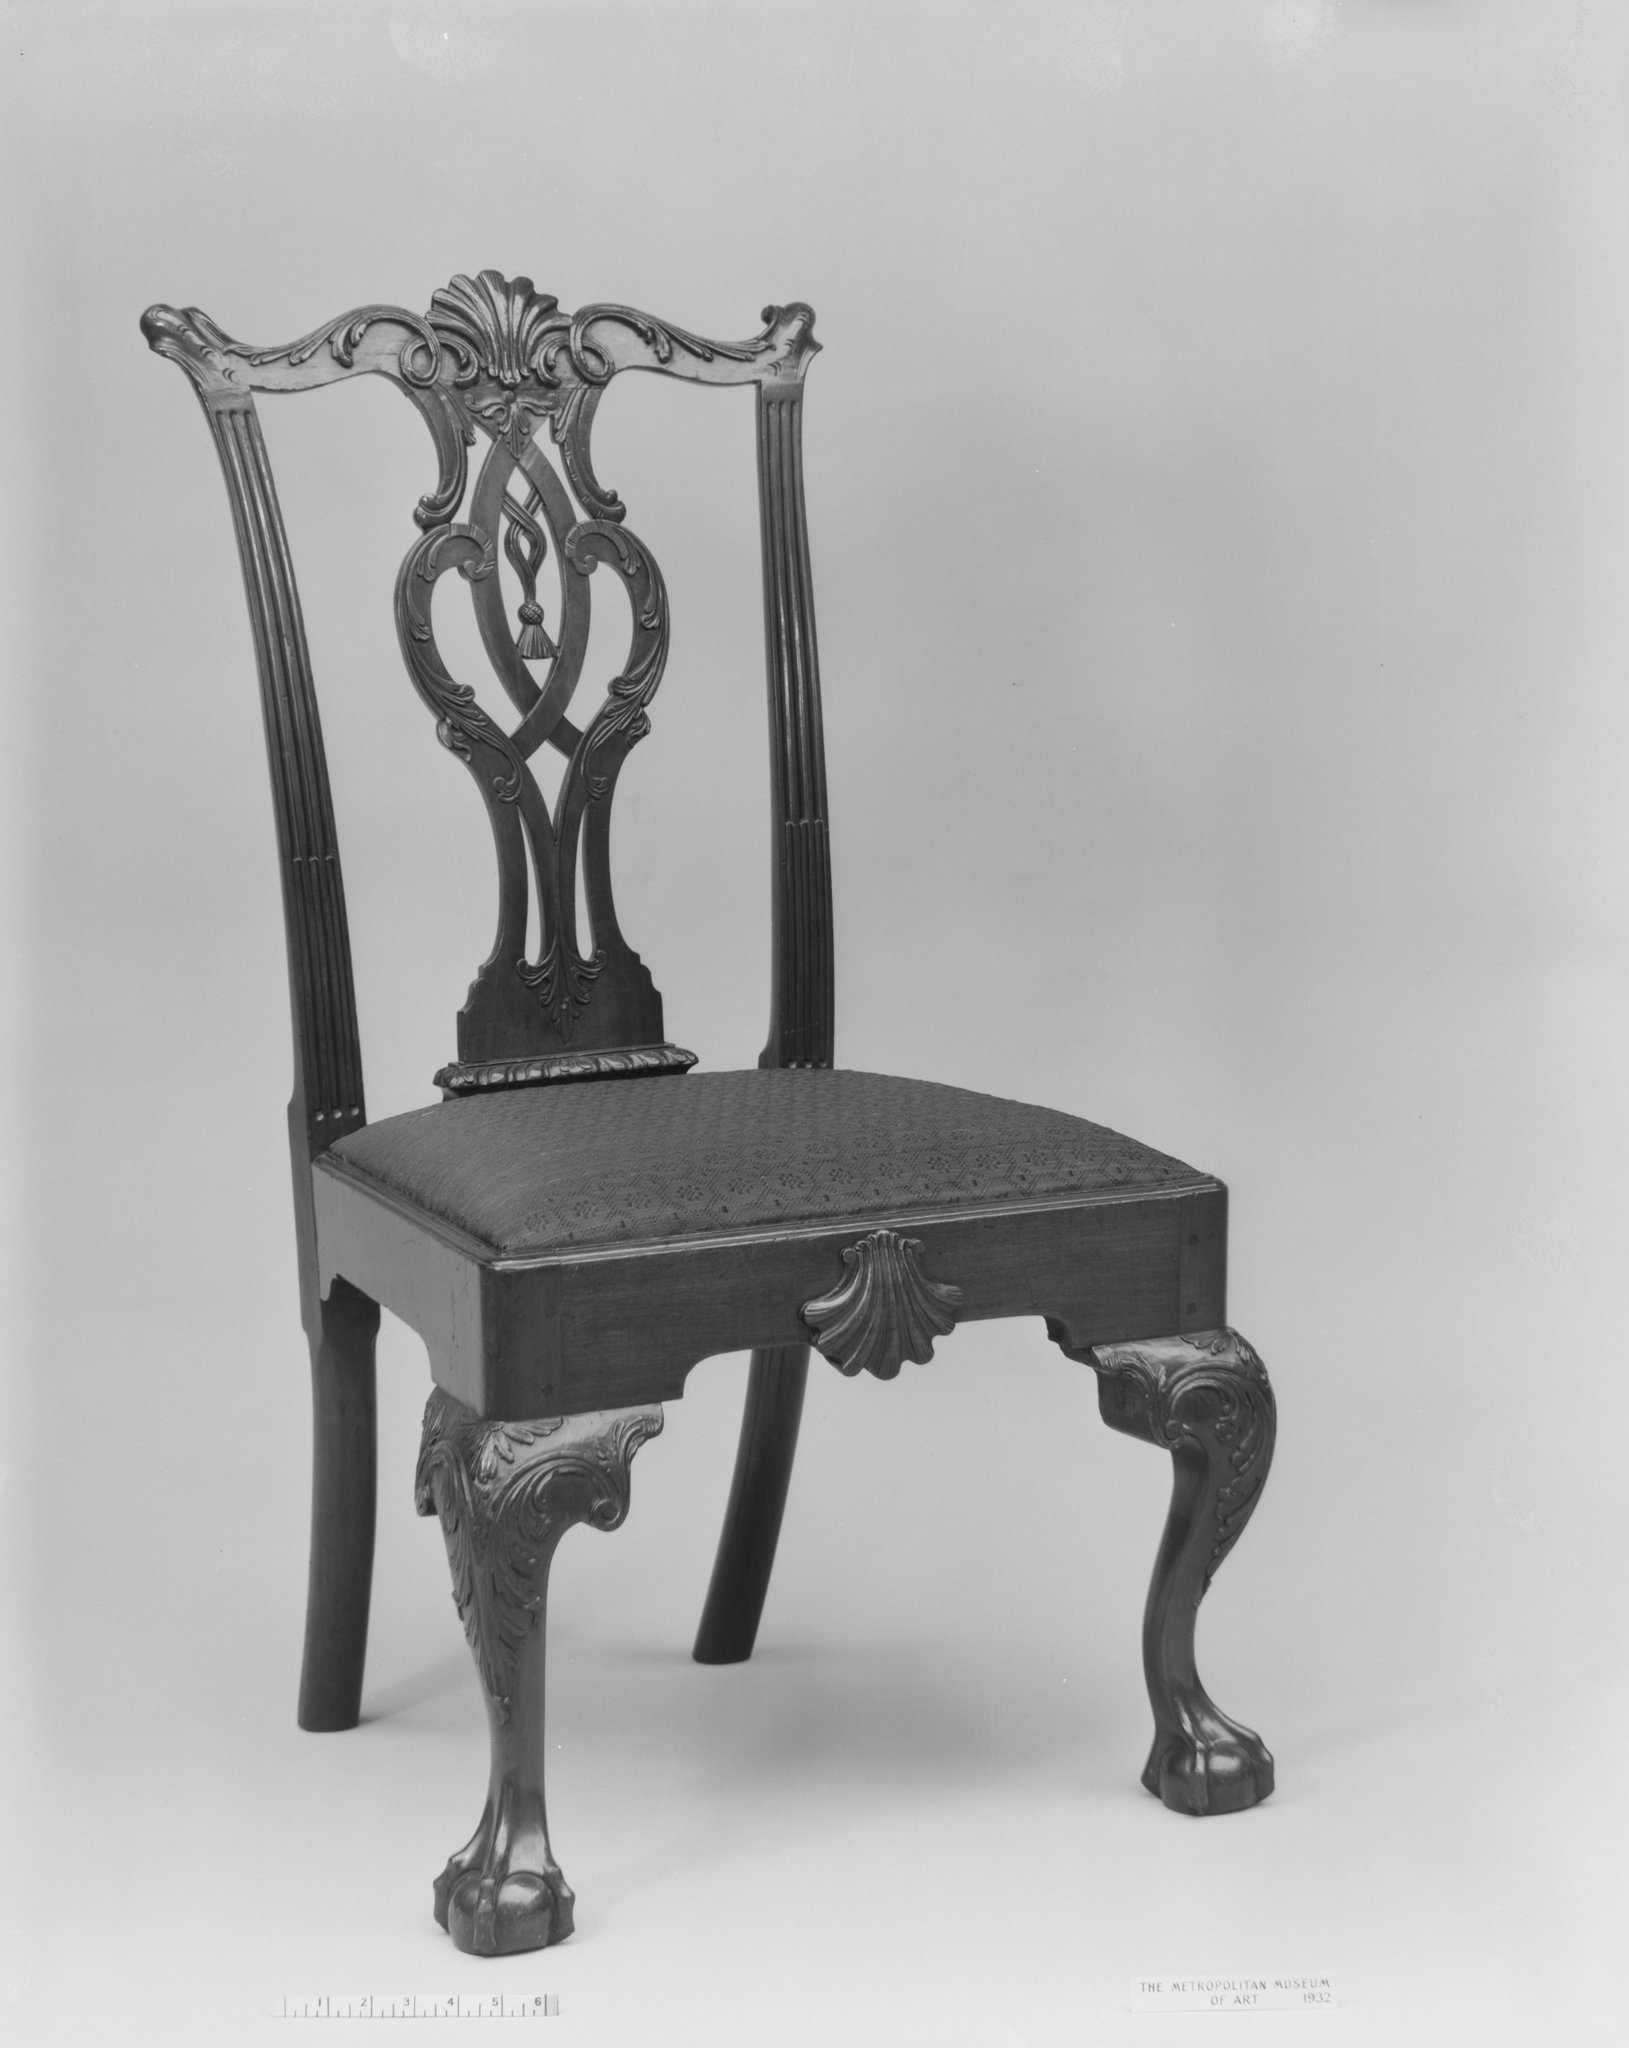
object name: side chair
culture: american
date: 1760-1790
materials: wood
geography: united states